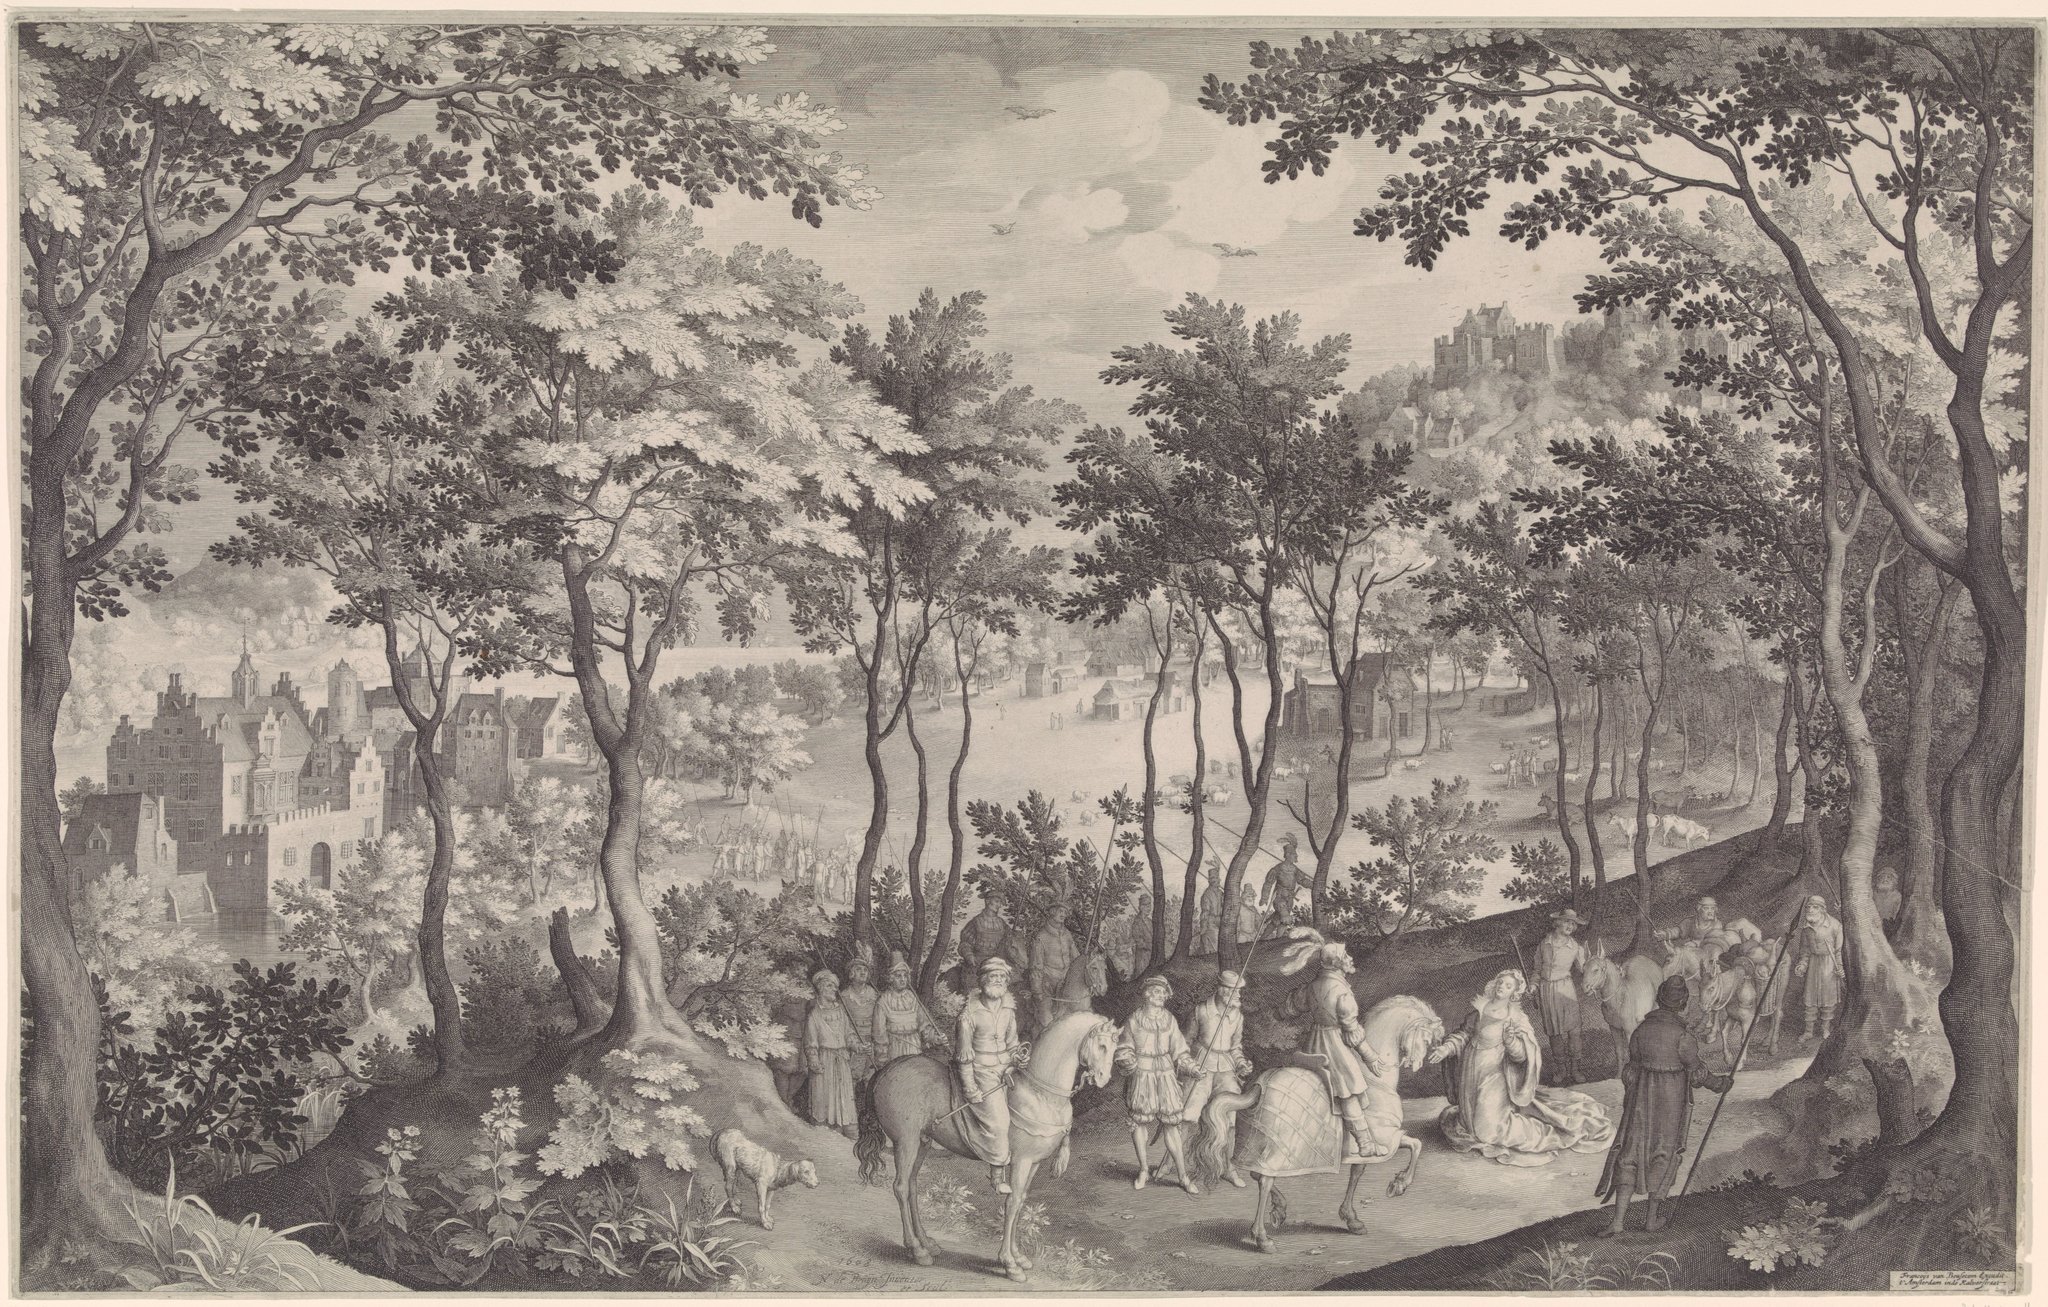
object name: print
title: David en Abigaïl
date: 1608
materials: paper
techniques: engraving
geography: amsterdam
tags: castle, meeting of david and abigail, who kneels before him, dale, valley (+ landscape with figures, staffage), farm (building)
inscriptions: collector's mark: Lugt 2228, inscription: ‘LeBl 12’, collector's mark: Lugt 523, collector's mark: Lugt 2610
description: Wanneer een gierige boer weigert David en zijn manschappen te helpen, dreigen ze hem te straffen. Abigaïl, de vrouw van de boer, knielt voor David en biedt hem en zijn soldaten eten en drinken aan. Achter haar enkele bedienden en drie ezels bepakt met drank en voedsel. Op de achtergrond een landschap met een kasteel en enkele boerderijen.